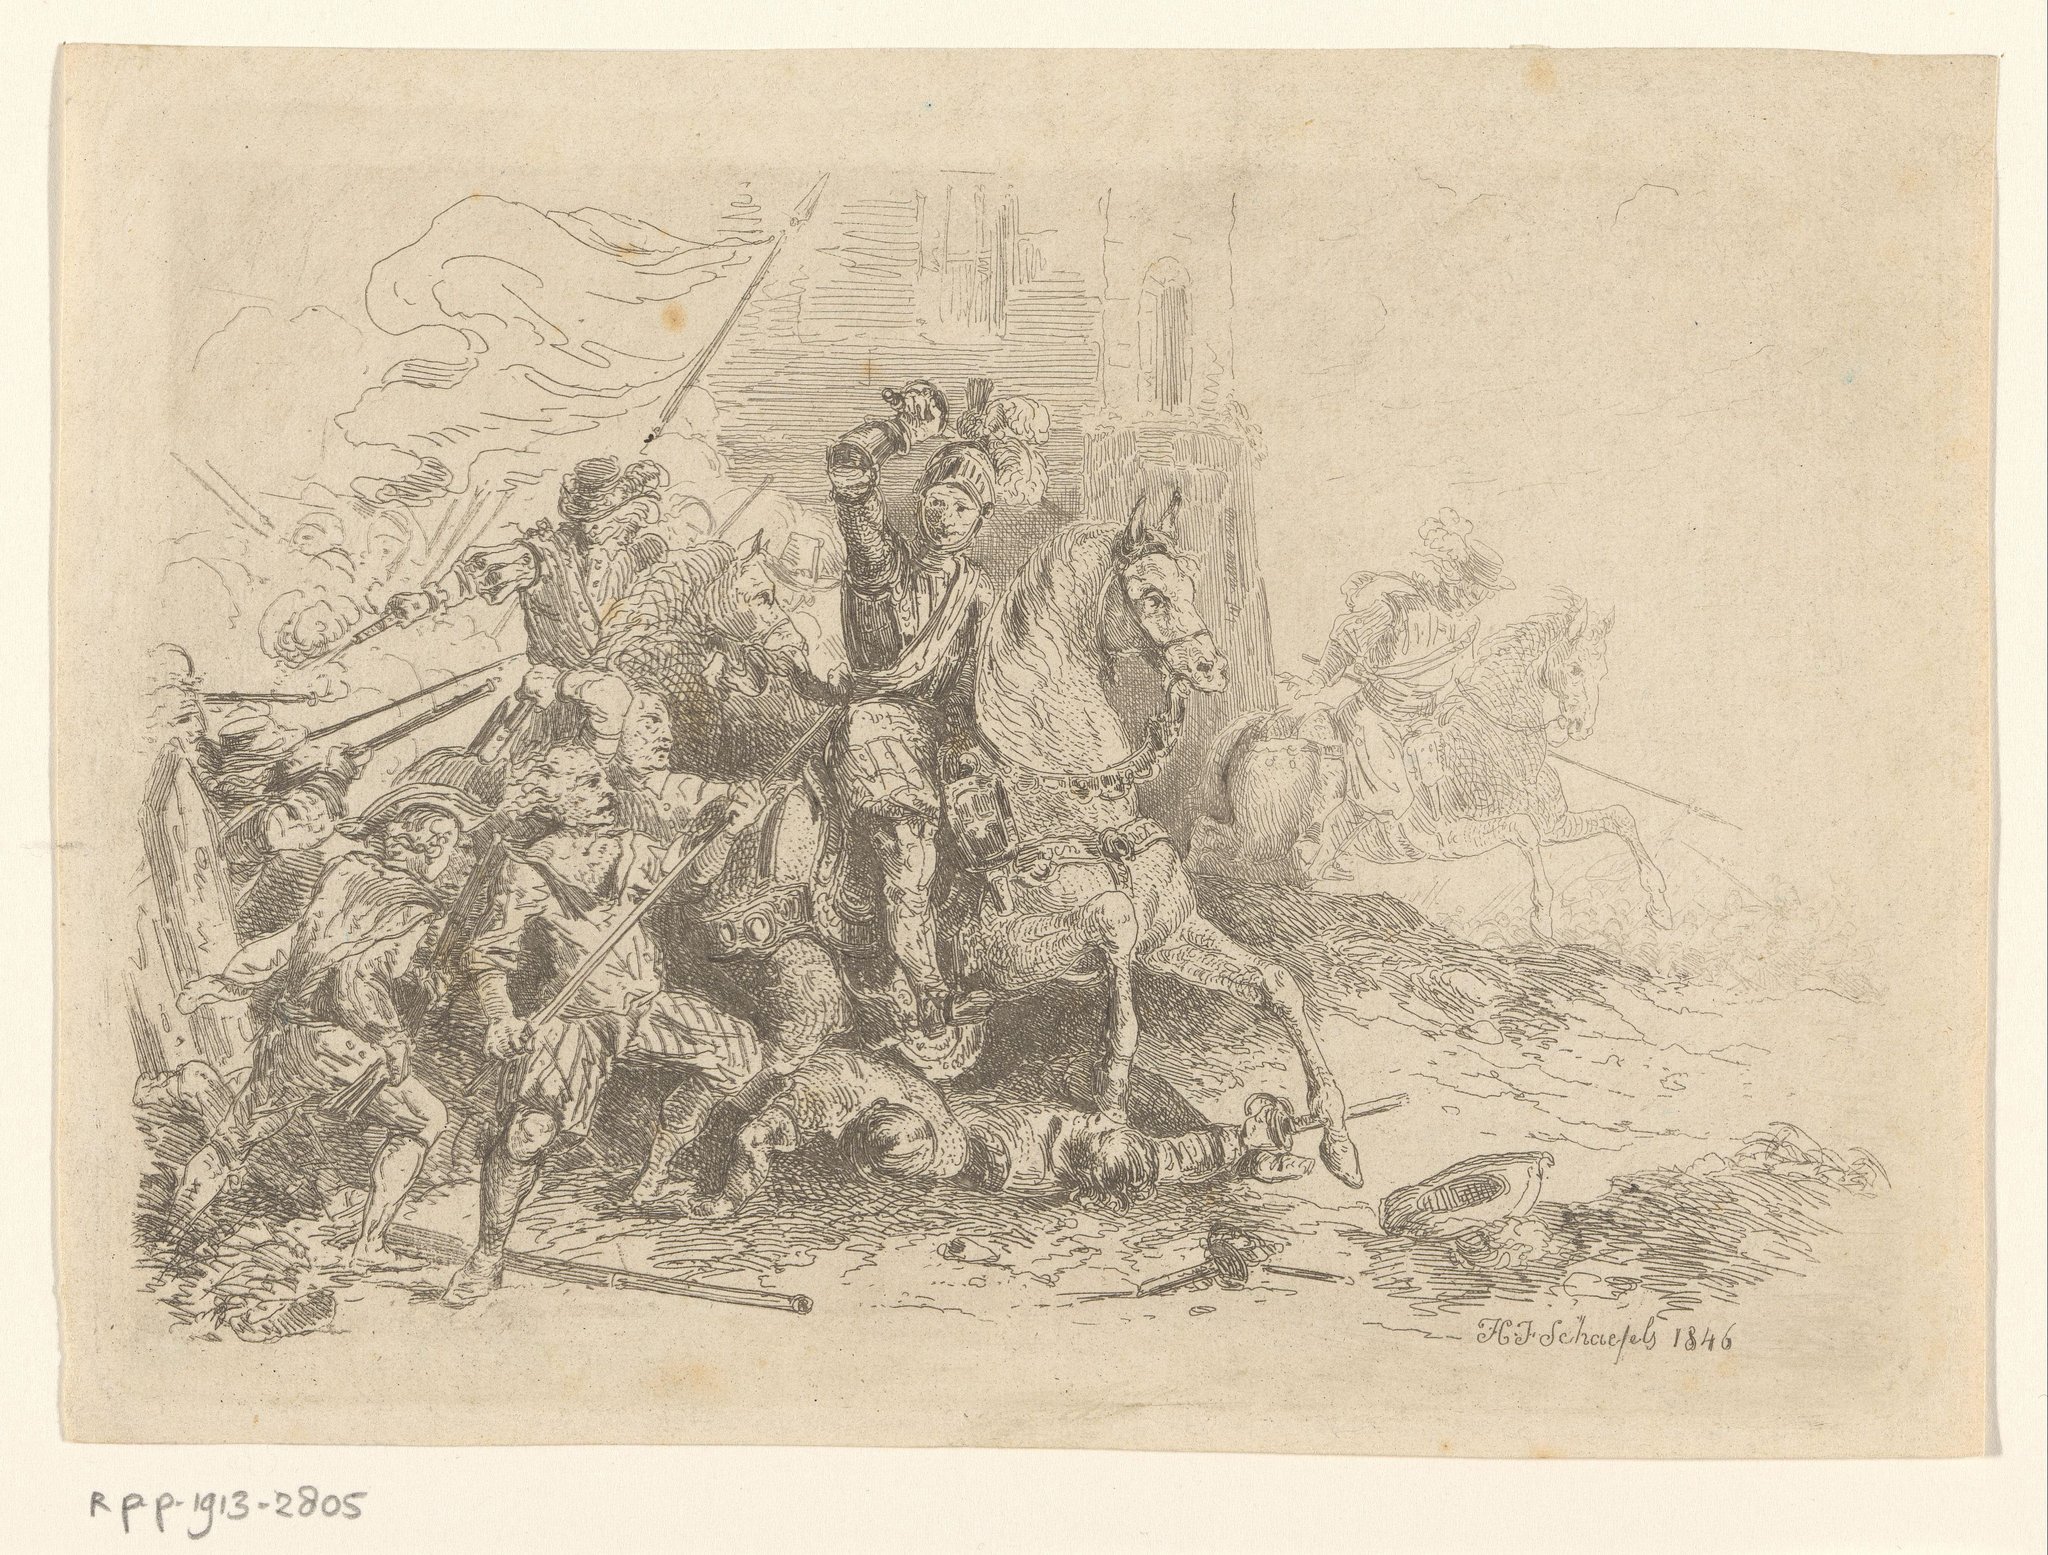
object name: print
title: Strijdscène met ruiter te paard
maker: henri françois schaefels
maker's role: print maker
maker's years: 1827-1904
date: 1846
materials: paper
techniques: etching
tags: paris, françois-hercule de valois (hertog van anjou), battle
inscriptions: collector's mark: Lugt 1485, collector's mark: Lugt 2228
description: De ruiter te paard is waarschijnlijk François Hercule de Valois die met zijn troepen Antwerpen probeert te veroveren in 1583.